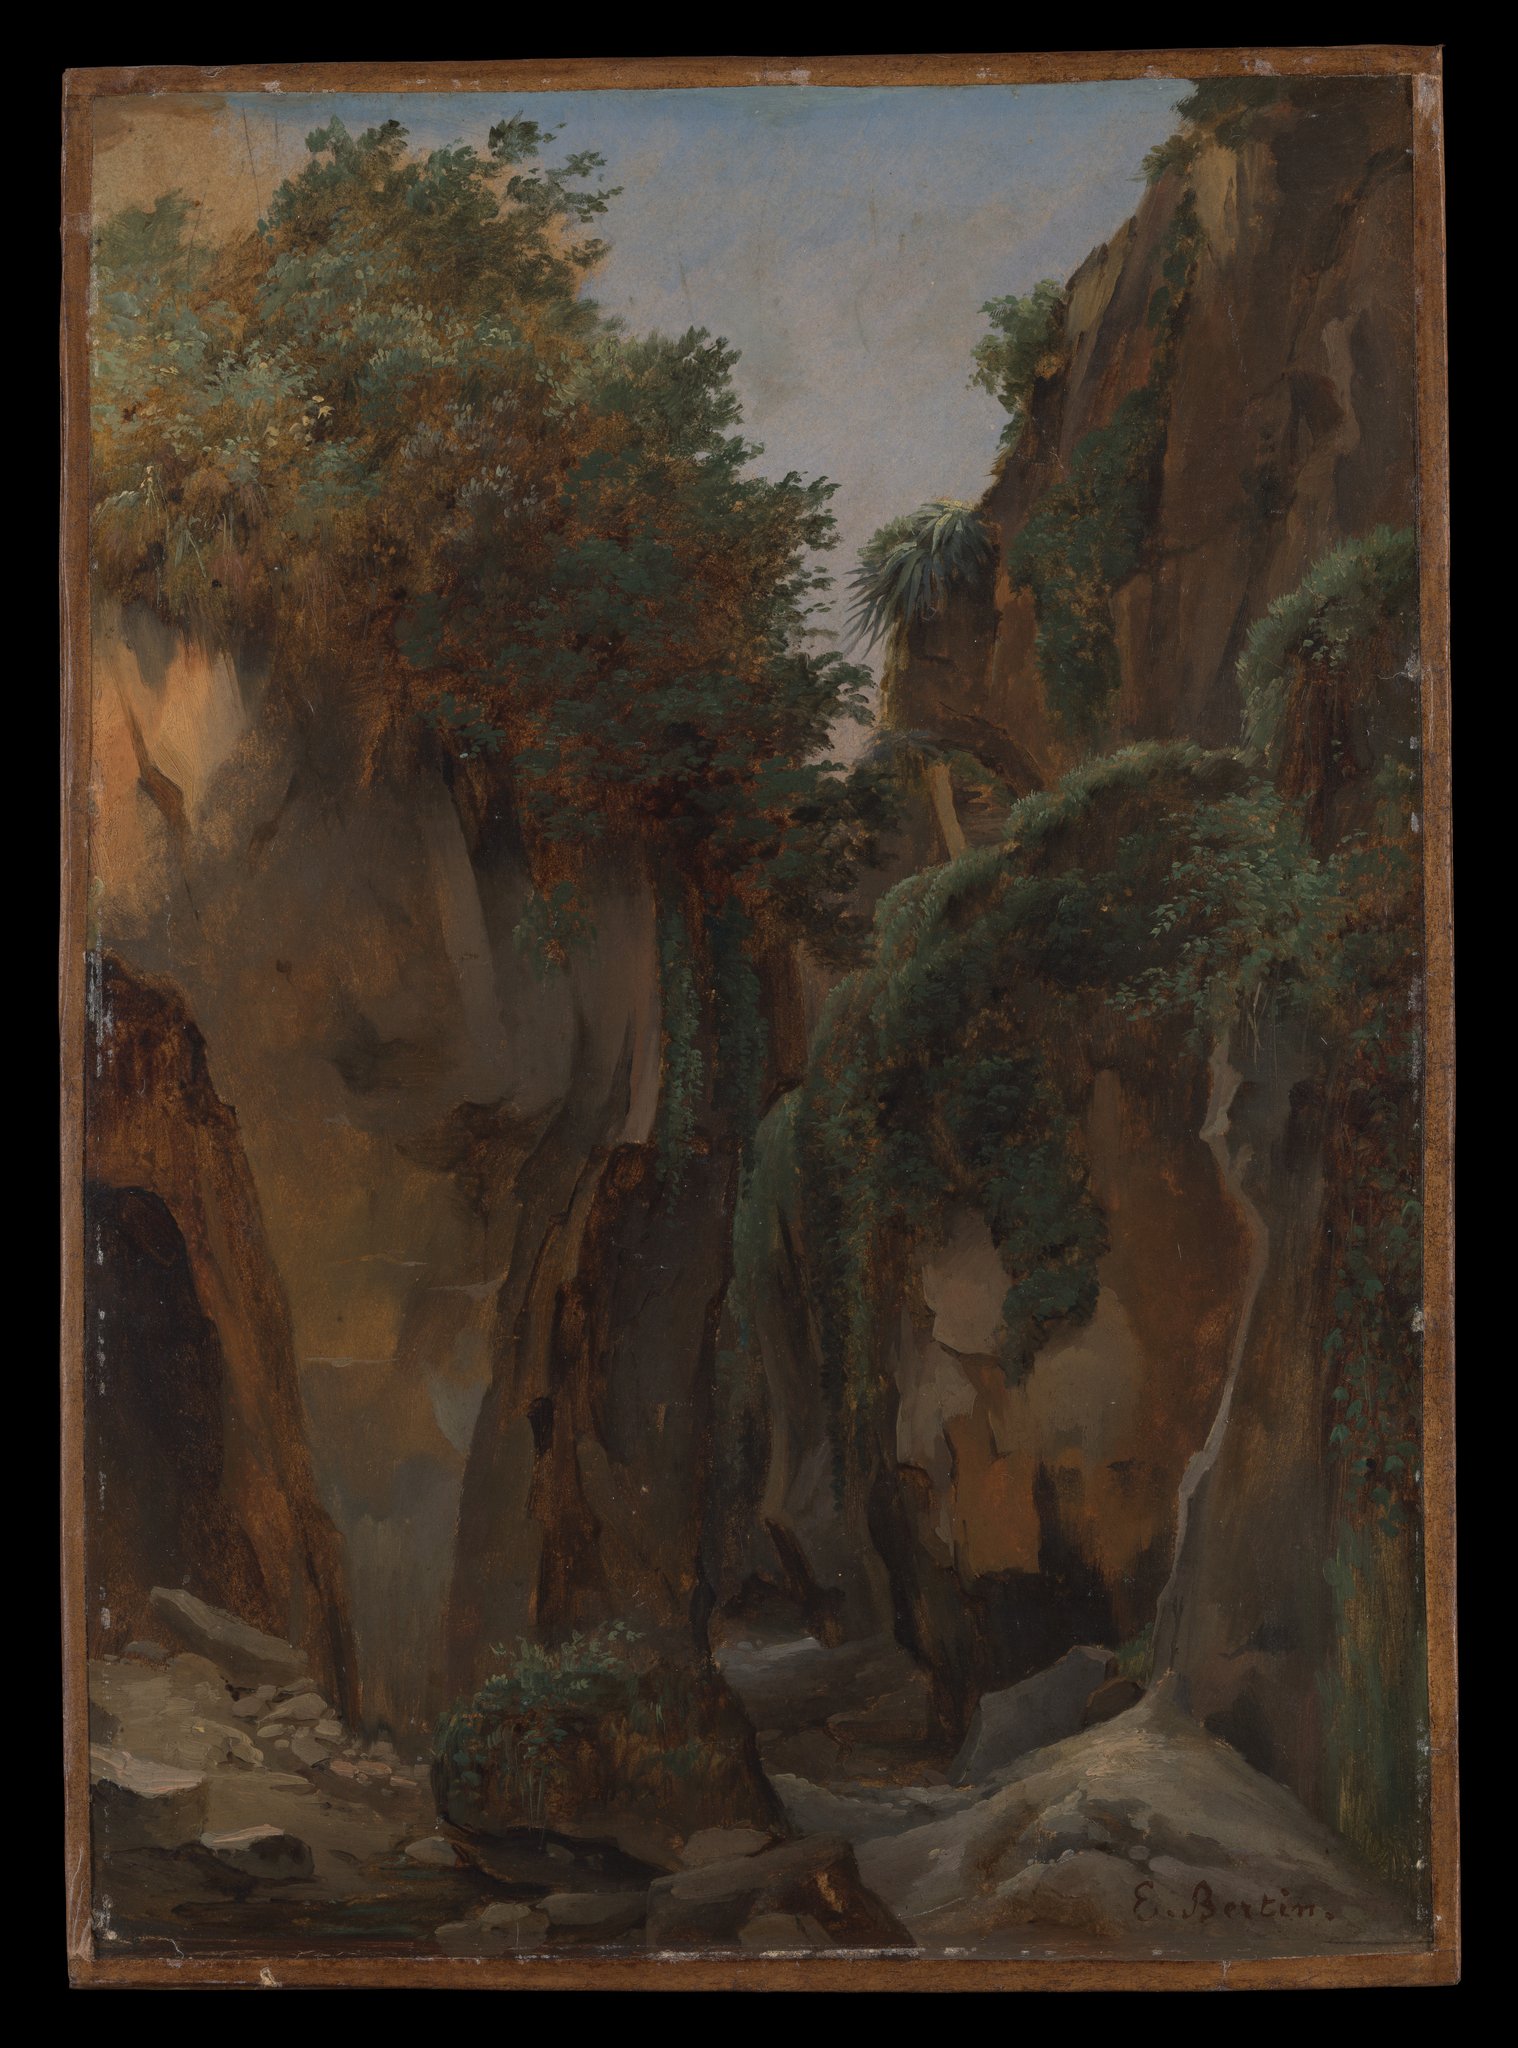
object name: drawing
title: Ravine at Sorrento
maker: edouard bertin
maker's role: artist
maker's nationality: french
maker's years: 1797-1871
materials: board, oil, paper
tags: landscapes